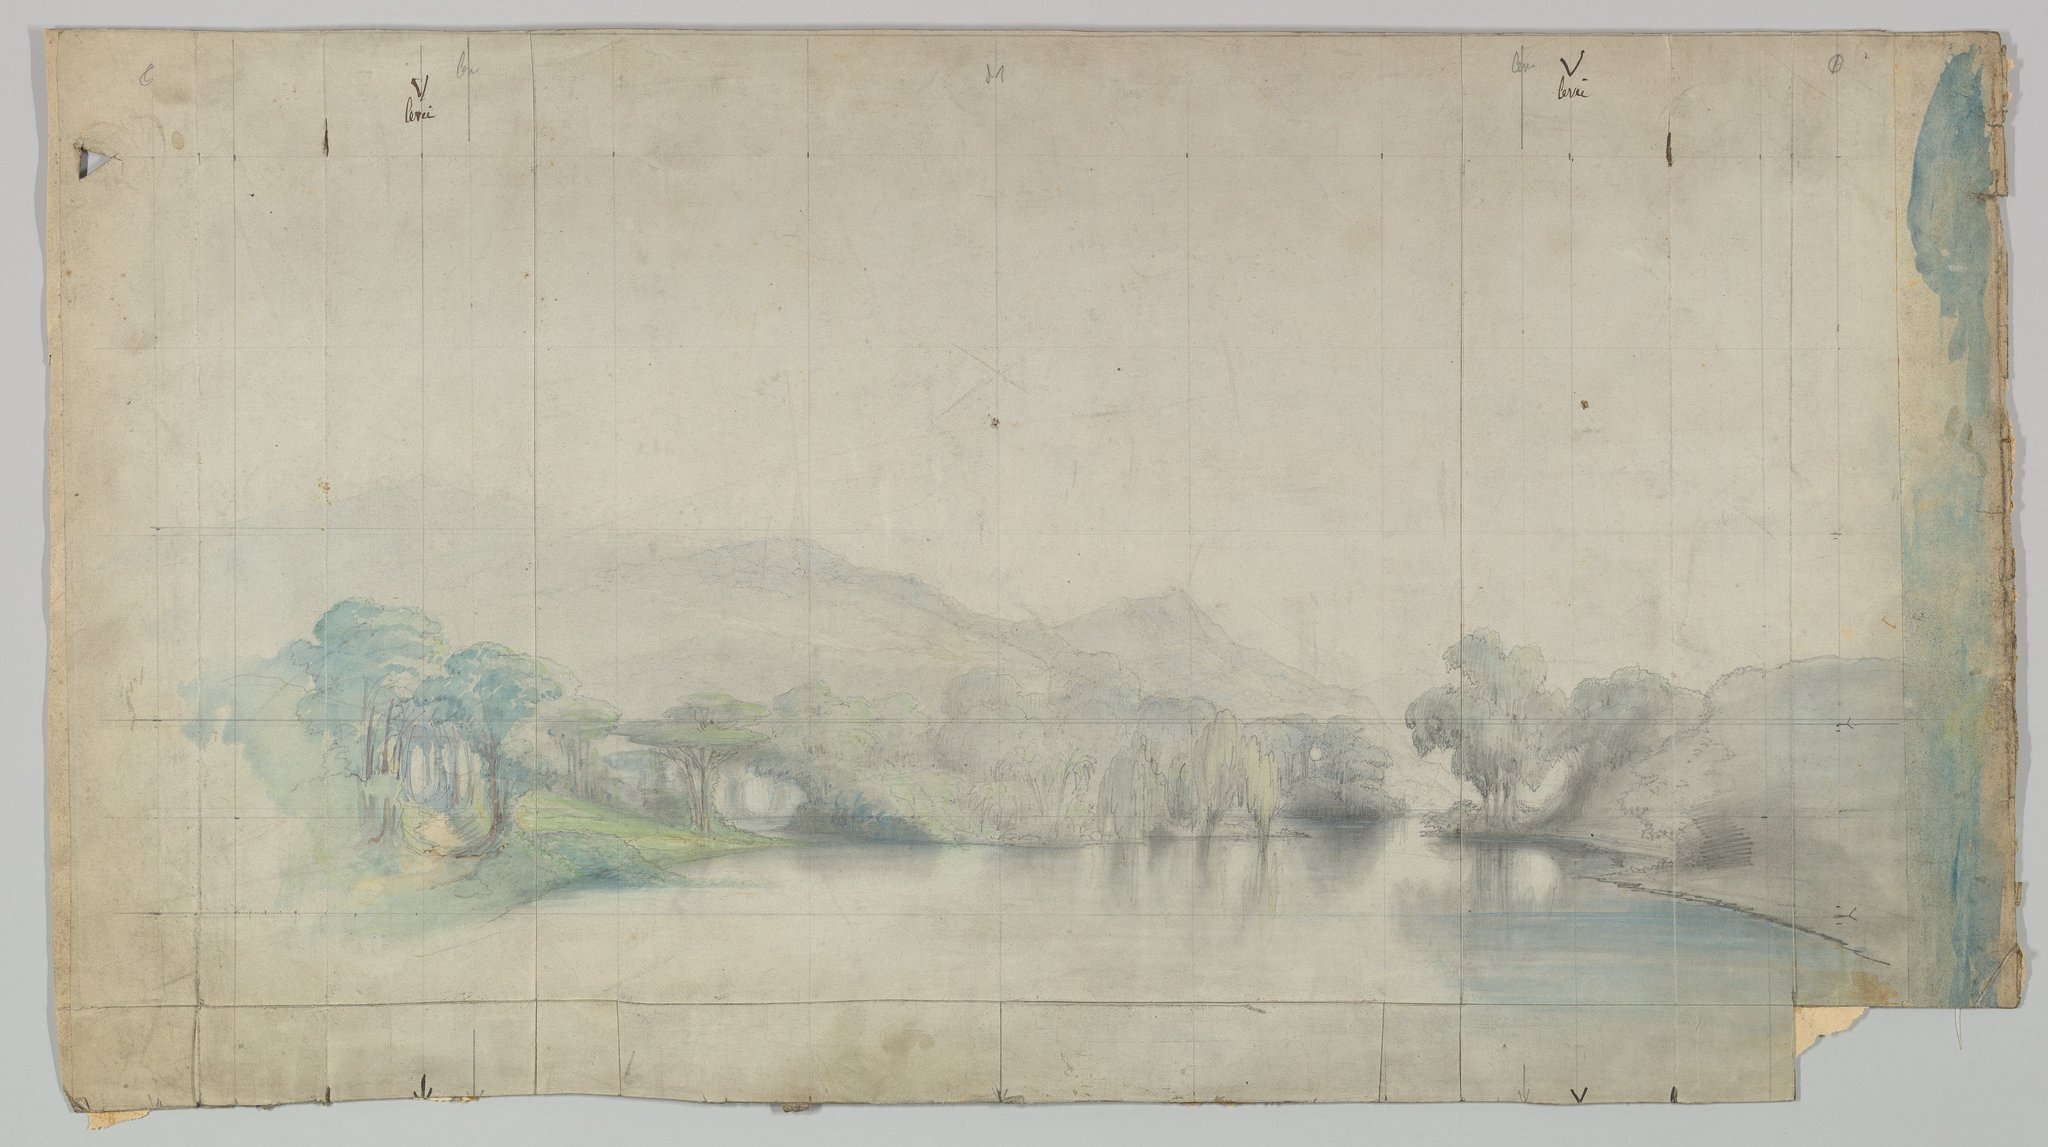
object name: drawing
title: Design for a Stage Set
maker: eugène cicéri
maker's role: artist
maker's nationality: french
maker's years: 1813-1890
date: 1830-1890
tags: landscapes,stage design